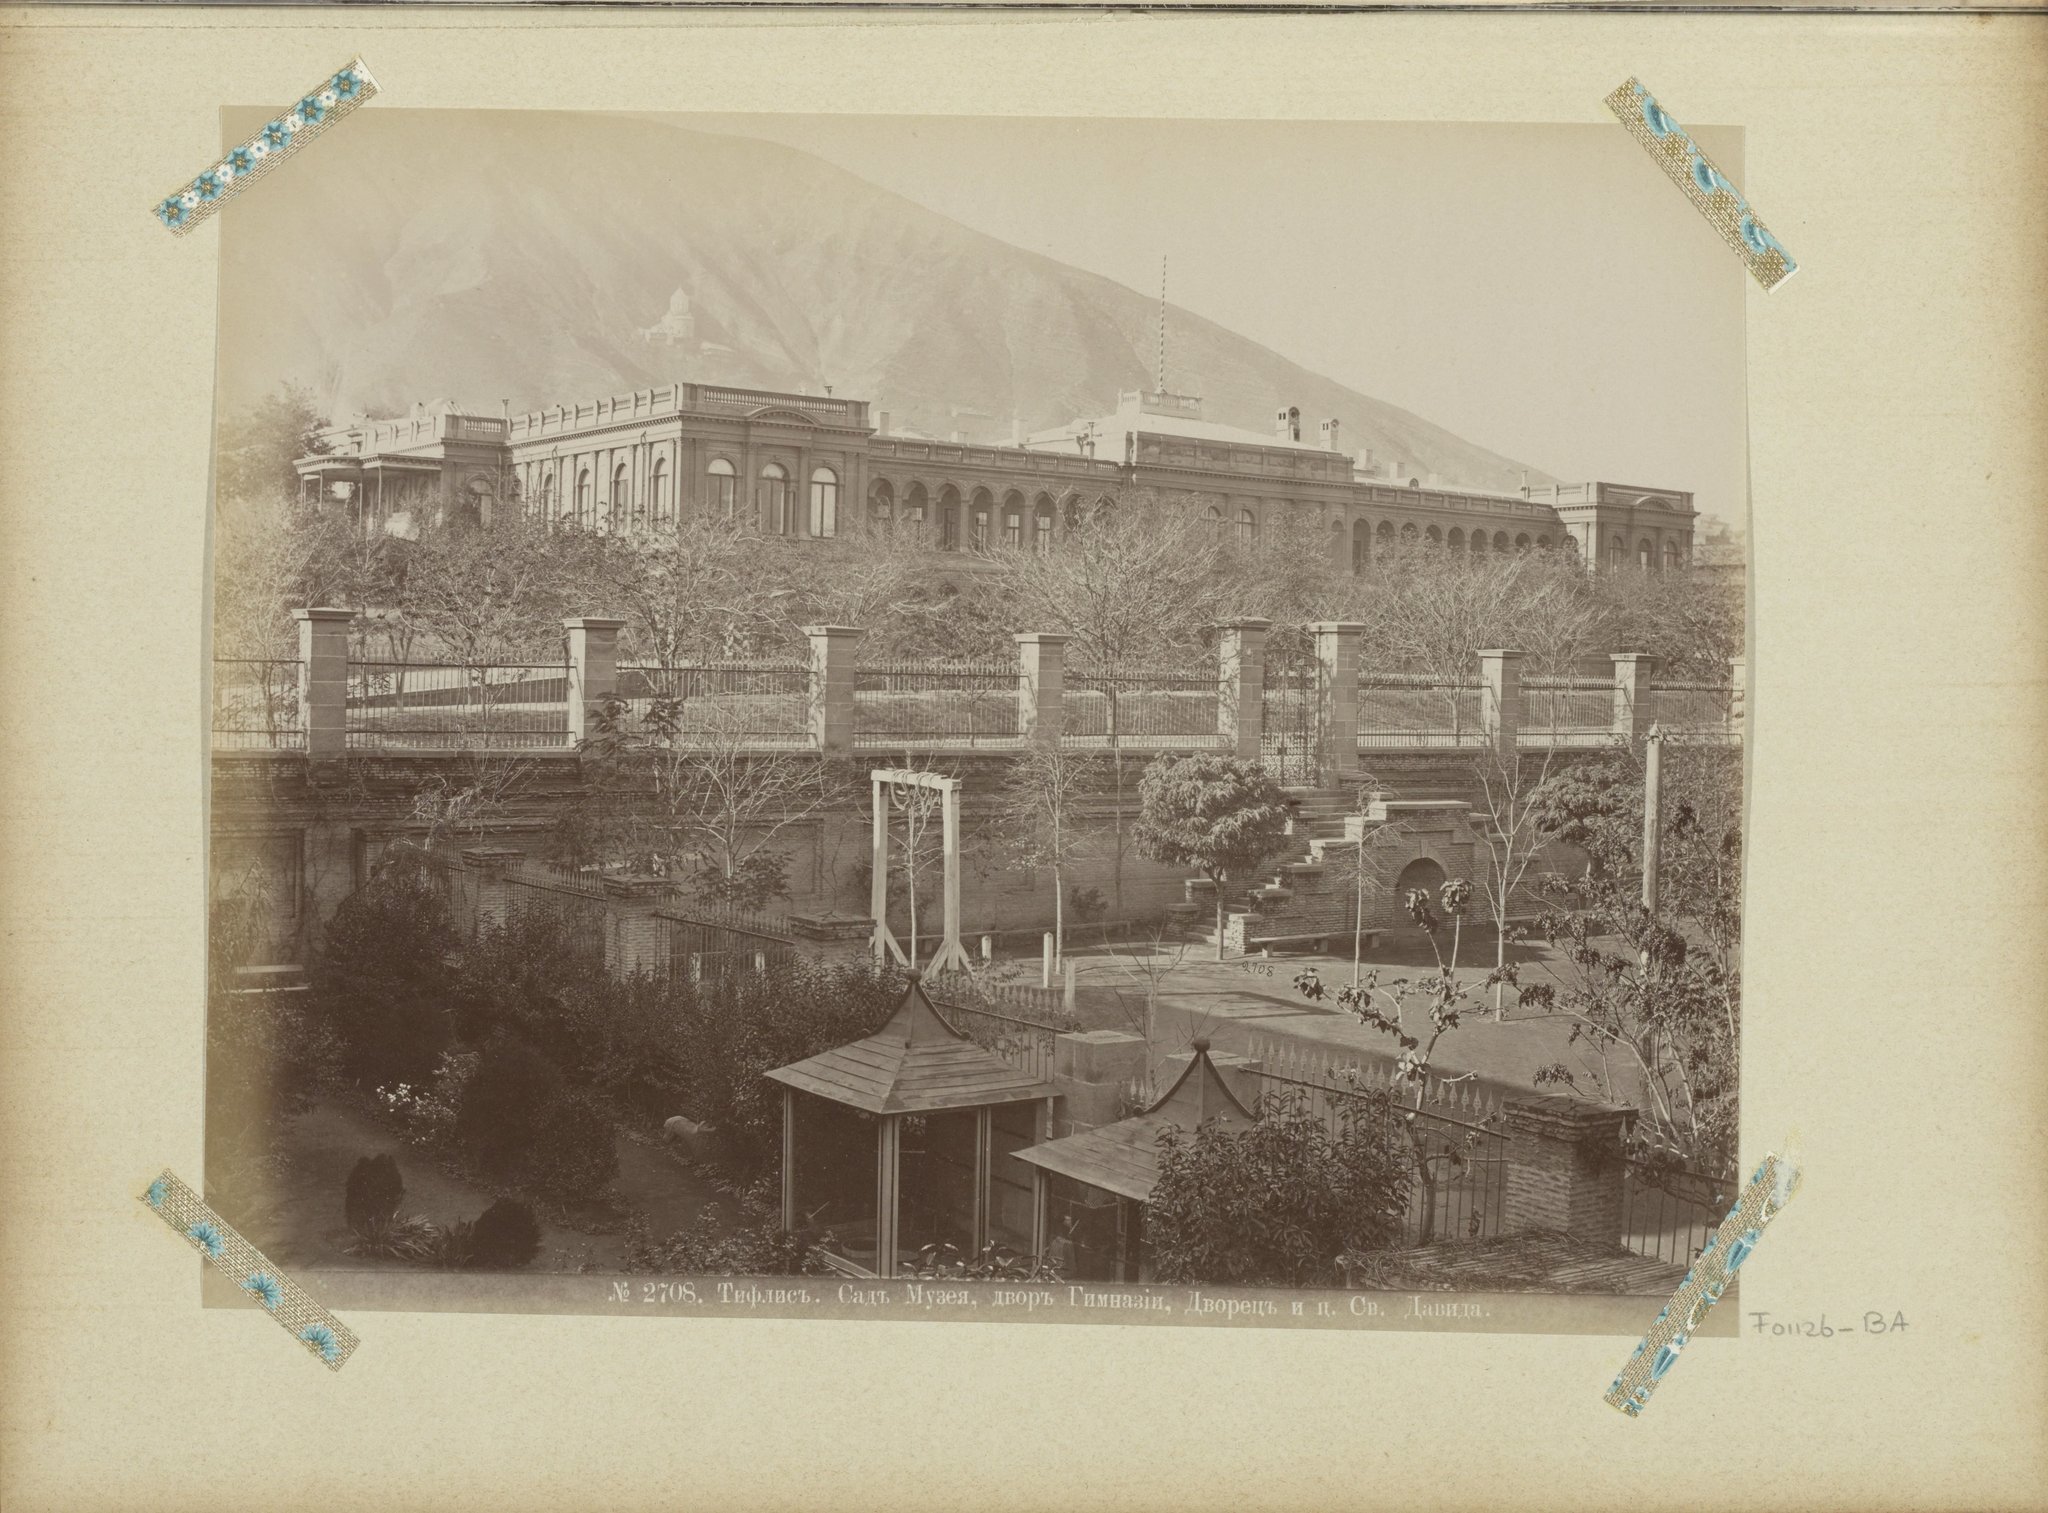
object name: photograph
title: Tiflis, Sad Moezjoja, dwor Gymnasia, dworjots i p.Sw.Dawida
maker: Anonymous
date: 1890-1900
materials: photographic support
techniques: albumen print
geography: tbilisi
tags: garden, exterior ~ representation of a building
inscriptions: number: ‘2708’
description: Onderdeel van Fotoalbum met opnames van bezienswaardigheden in Georgië, Sint-Petersburg en Moskou.